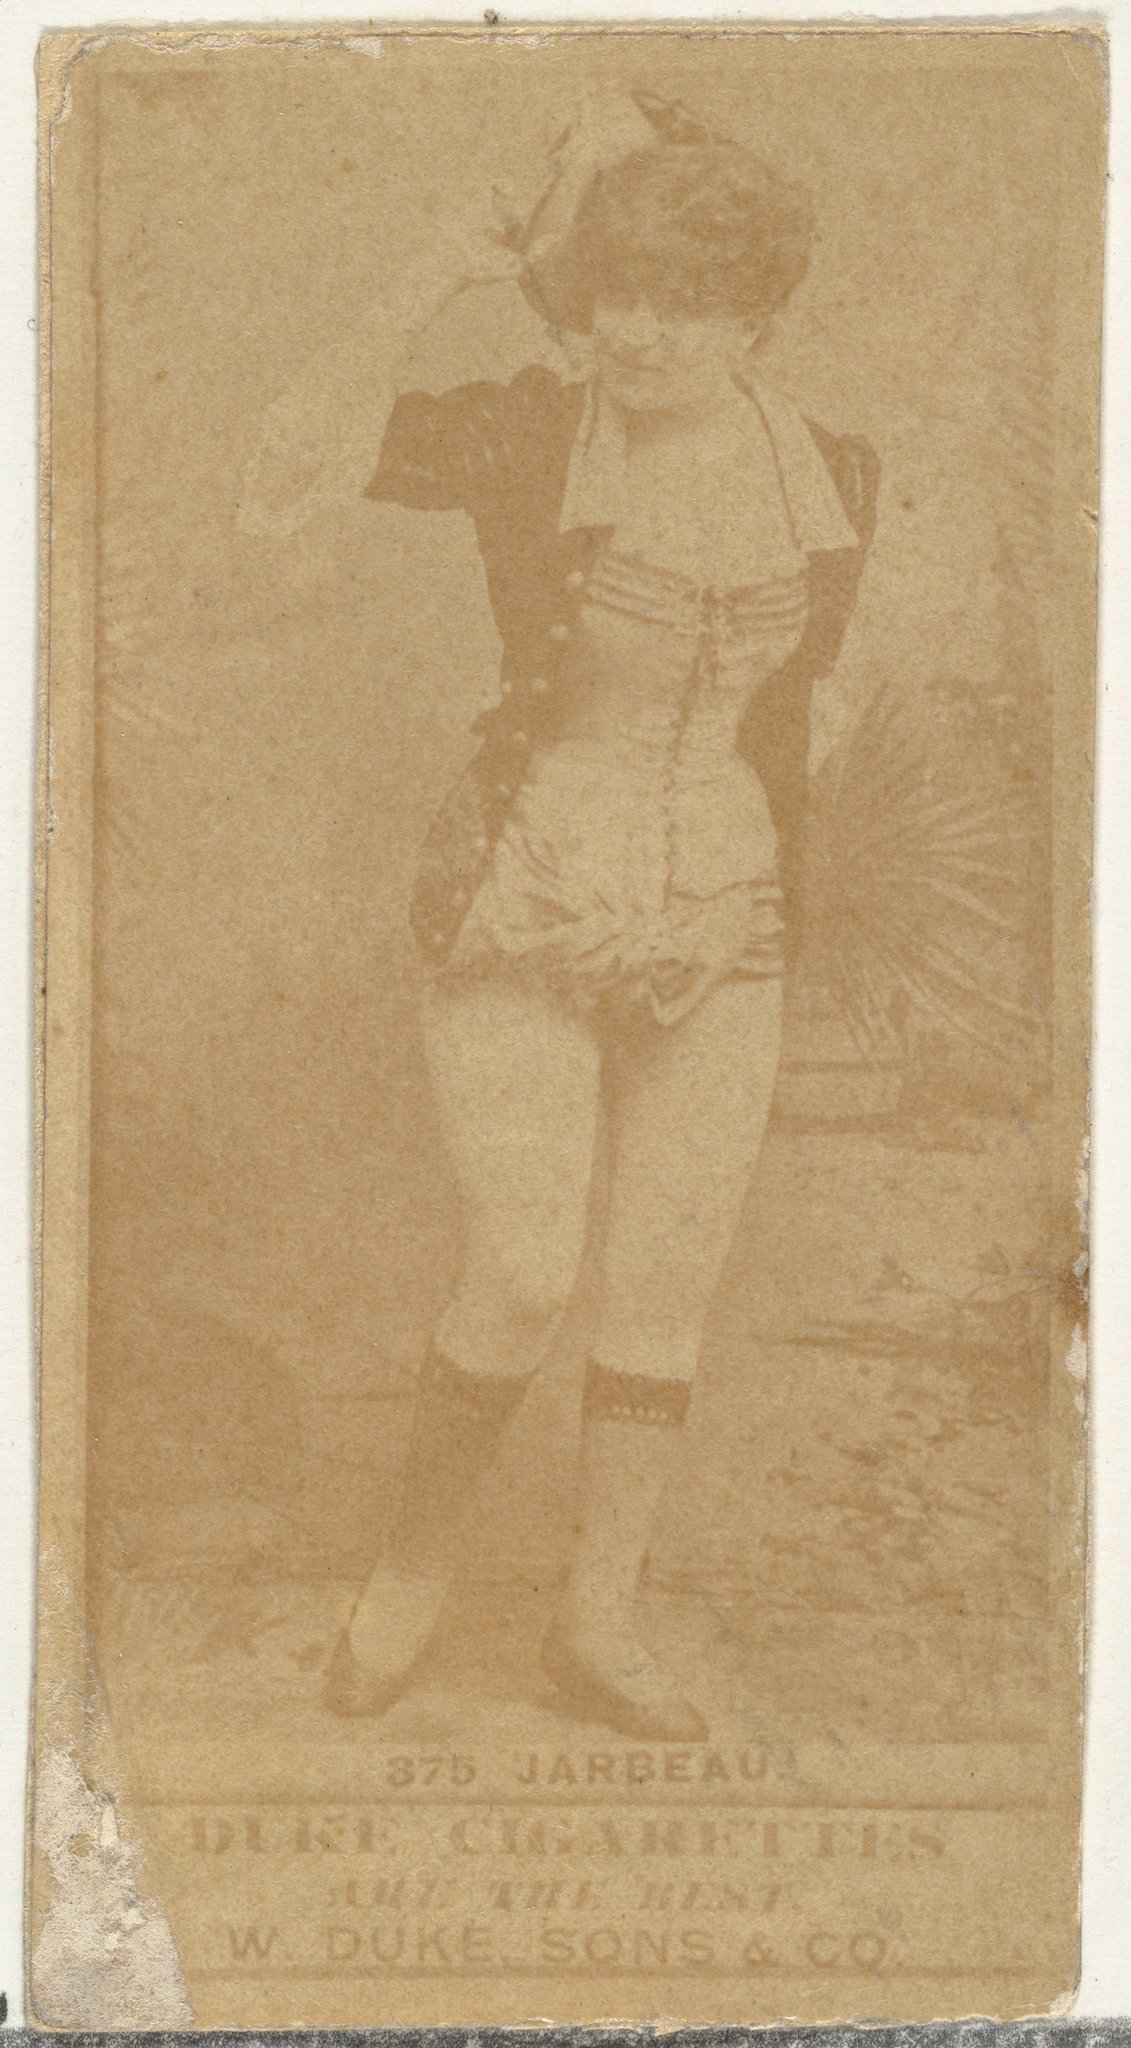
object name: photograph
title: Card Number 375, Miss Jarbeau, from the Actors and Actresses series (N145-7) issued by Duke Sons & Co. to promote Duke Cigarettes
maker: w. duke, sons & co.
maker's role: publisher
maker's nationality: american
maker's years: 1870-1920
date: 1880-1889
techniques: albumen silver print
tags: portraits,women,actresses